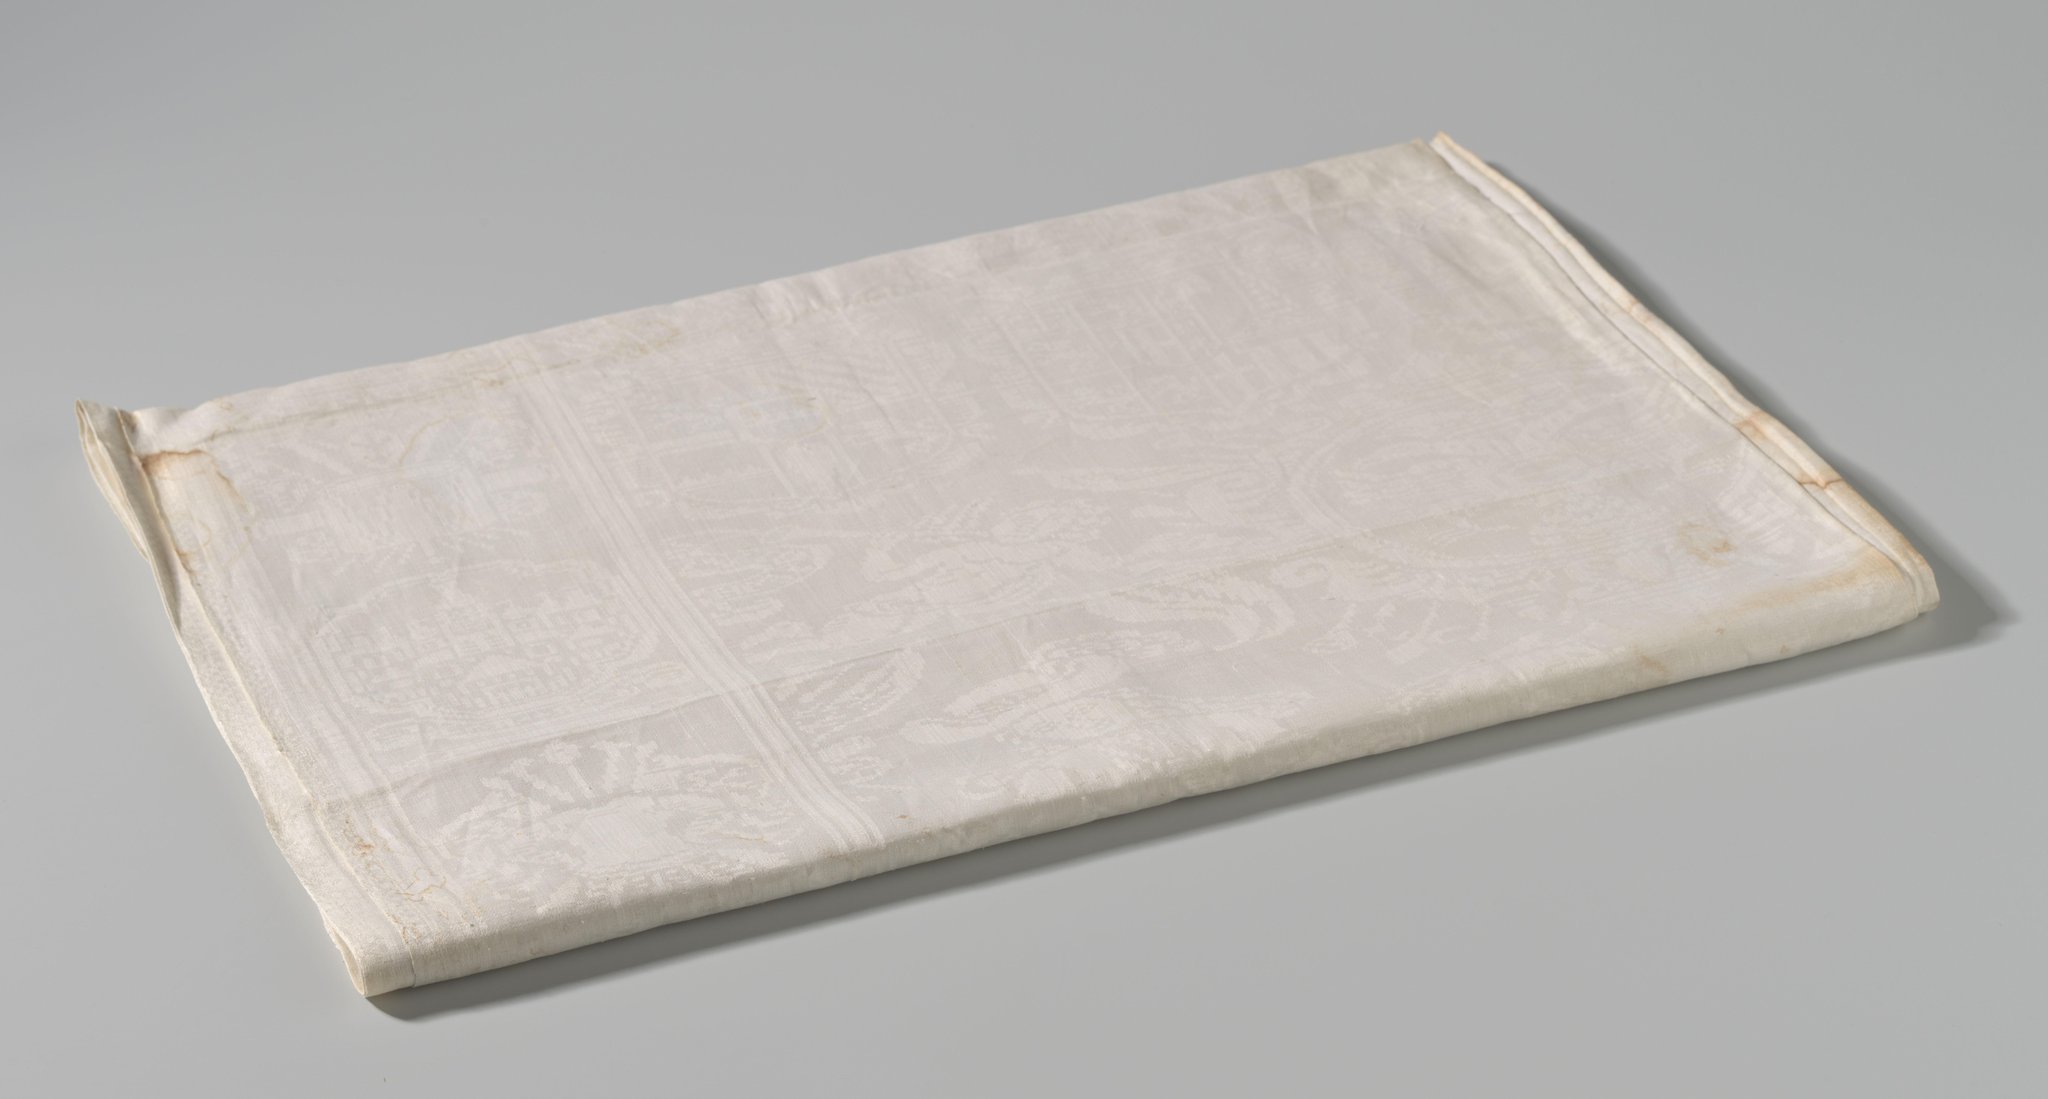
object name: tablecloth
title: Tafellaken van linnendamast met een historisch tafereel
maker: Anonymous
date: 1709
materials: linen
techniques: damask, weave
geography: kortrijk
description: Tafellaken van linnendamast met de hulde aan Jozef I. Het patroon herhaalt zich driemaal in de lengte en heeft de volgende taferelen: een ruiter, het opschrift VI VAT IOSEPHVS en RYSSEL, een stad, het opschrift MALPLACQVE, vechtende soldaten en ruiters, op rolwerk de gekroonde wapenschilden van de hertog van Marlborough en prins Eugenius van Savoye en daaronder op rolwerk en trofeeën het gekroonde wapen van het Heilige Roomse Rijk het hartschild Oostenrijk. De randen hebben cartouches waarbinnen steden.